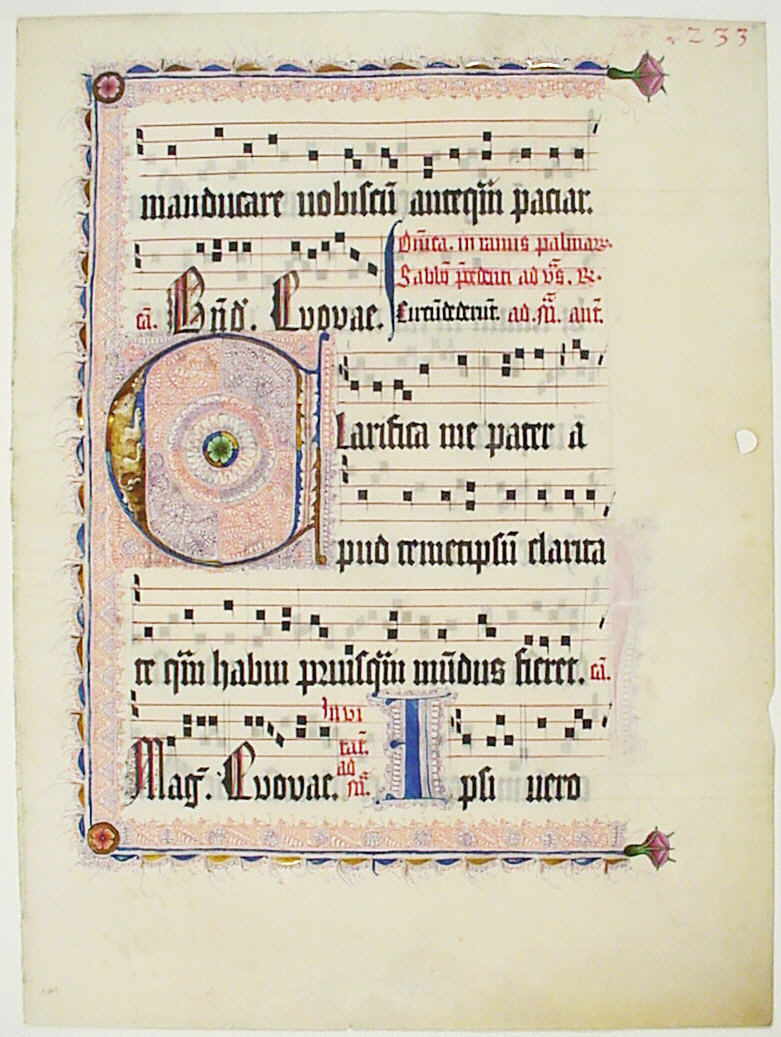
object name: antiphonary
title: Manuscript Leaf with Initial C, from an Antiphonary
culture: german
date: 1425-1450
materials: ink, metal leaf, parchment, paint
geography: germany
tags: music